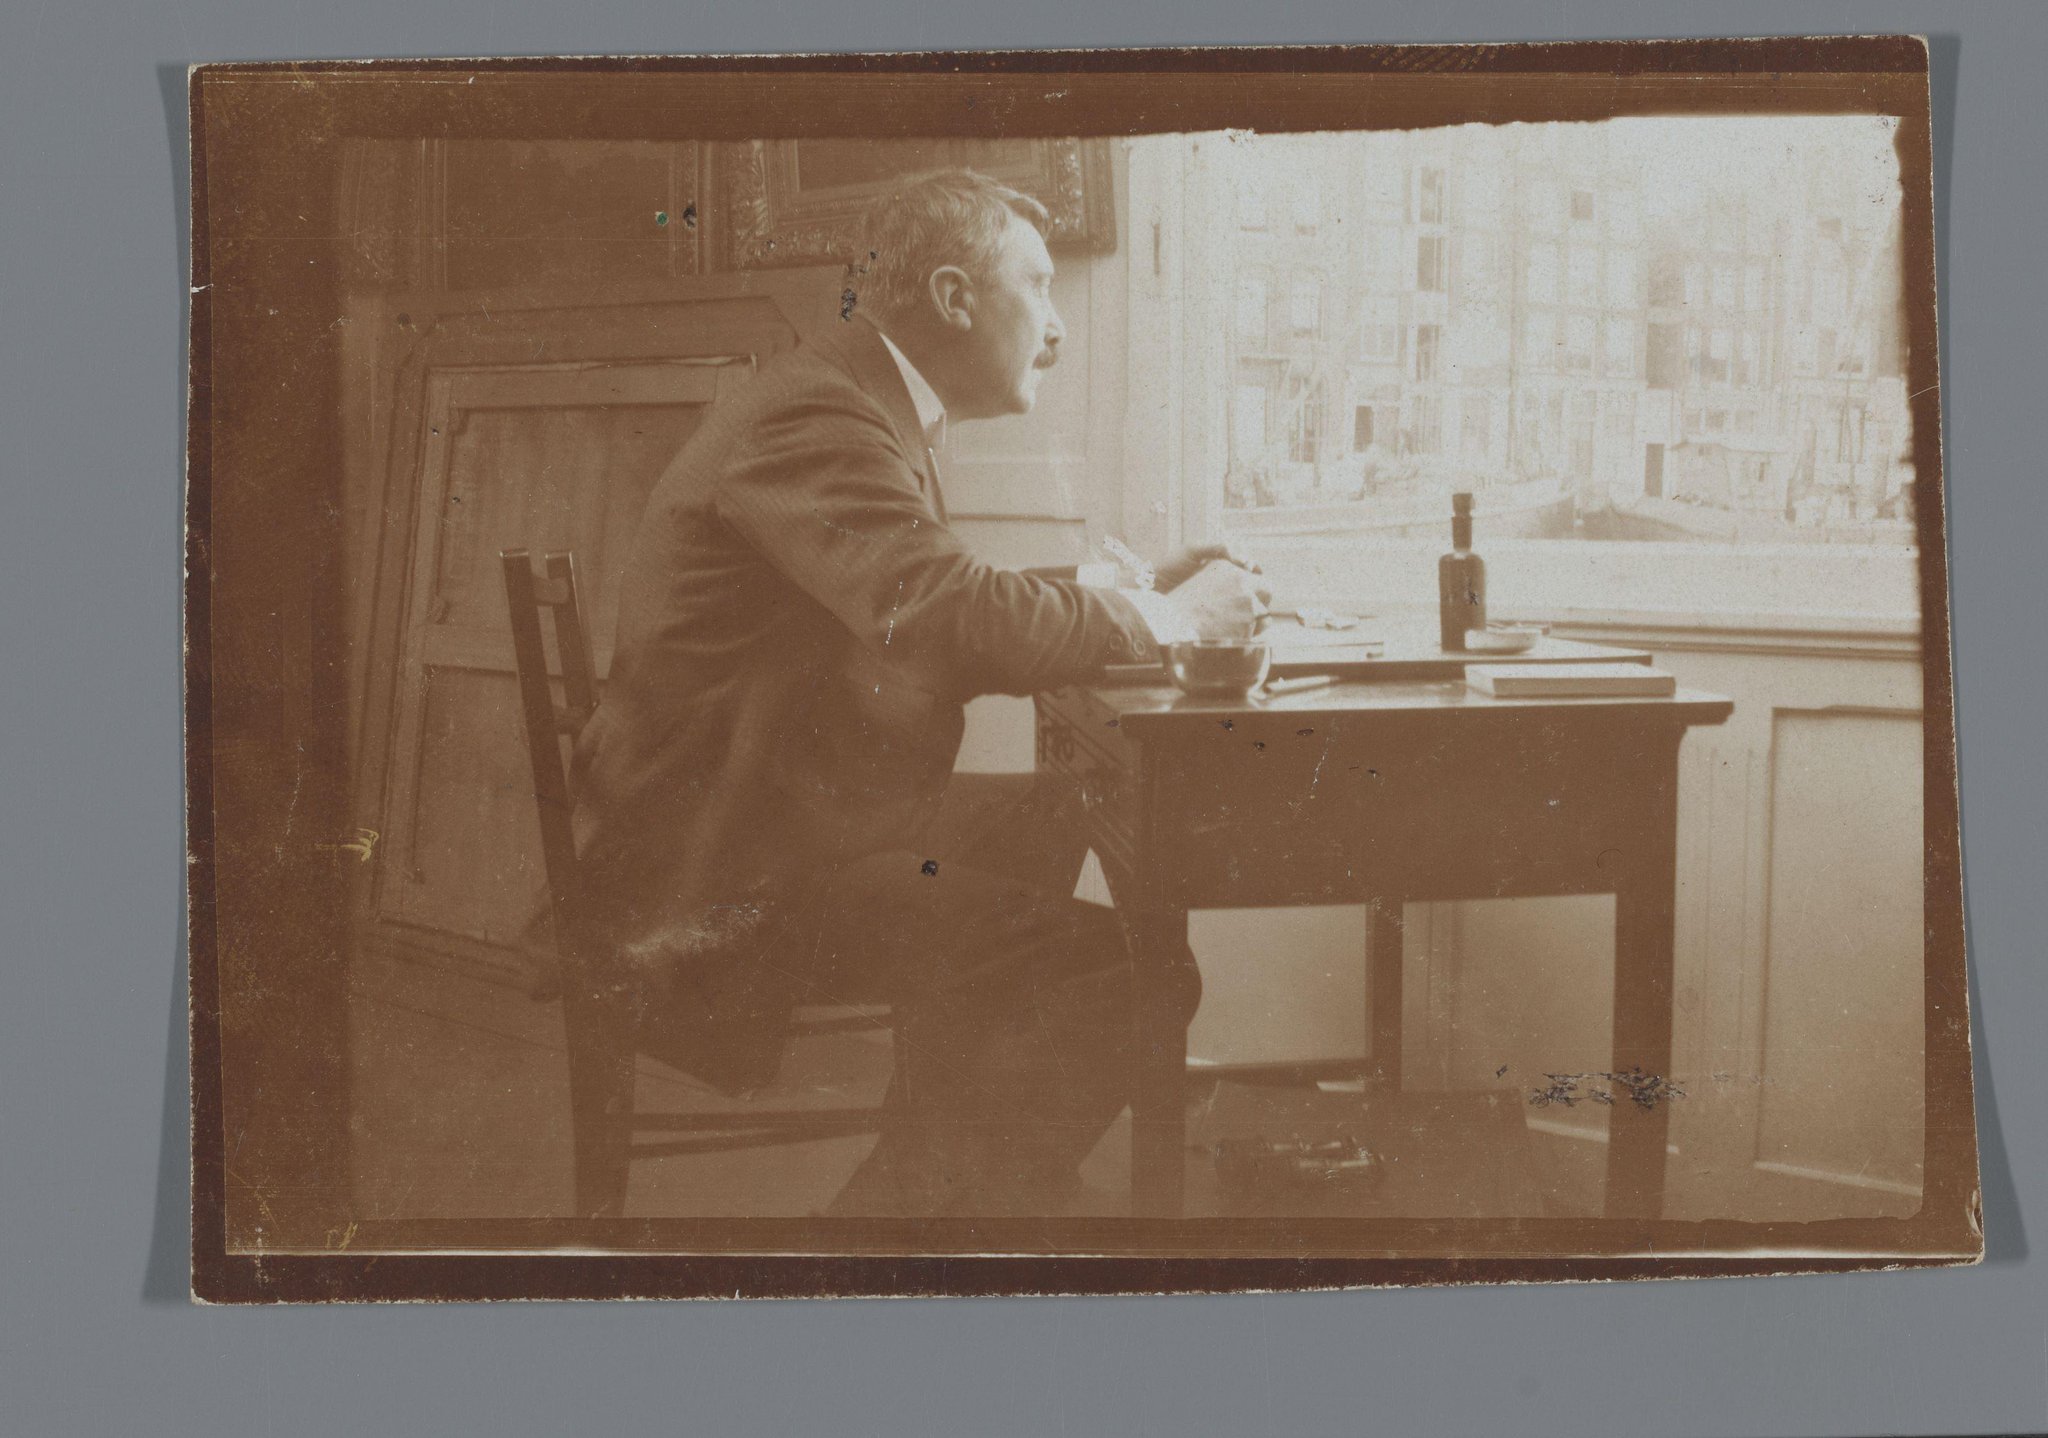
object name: photograph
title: Willem Witsen aan een bureau in zijn boot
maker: george hendrik breitner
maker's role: draughtsman, painter, print maker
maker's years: 1857-1923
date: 1911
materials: photographic support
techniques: collodion silver print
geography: amsterdam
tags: amsterdam, painter, print maker, draughtsman, willem witsen, writing-table, writing-desk, sitting figure (+ sideview, profile), portrait, self-portrait of artist, boat-house, shed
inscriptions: annotation: ‘1/1/ huizen duidelijker/ een [...]/ vlekje boven linker manchet wegmaken’, number: ‘2981’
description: Door het raam zijn de panden Kromme Waal 18-21 te zien